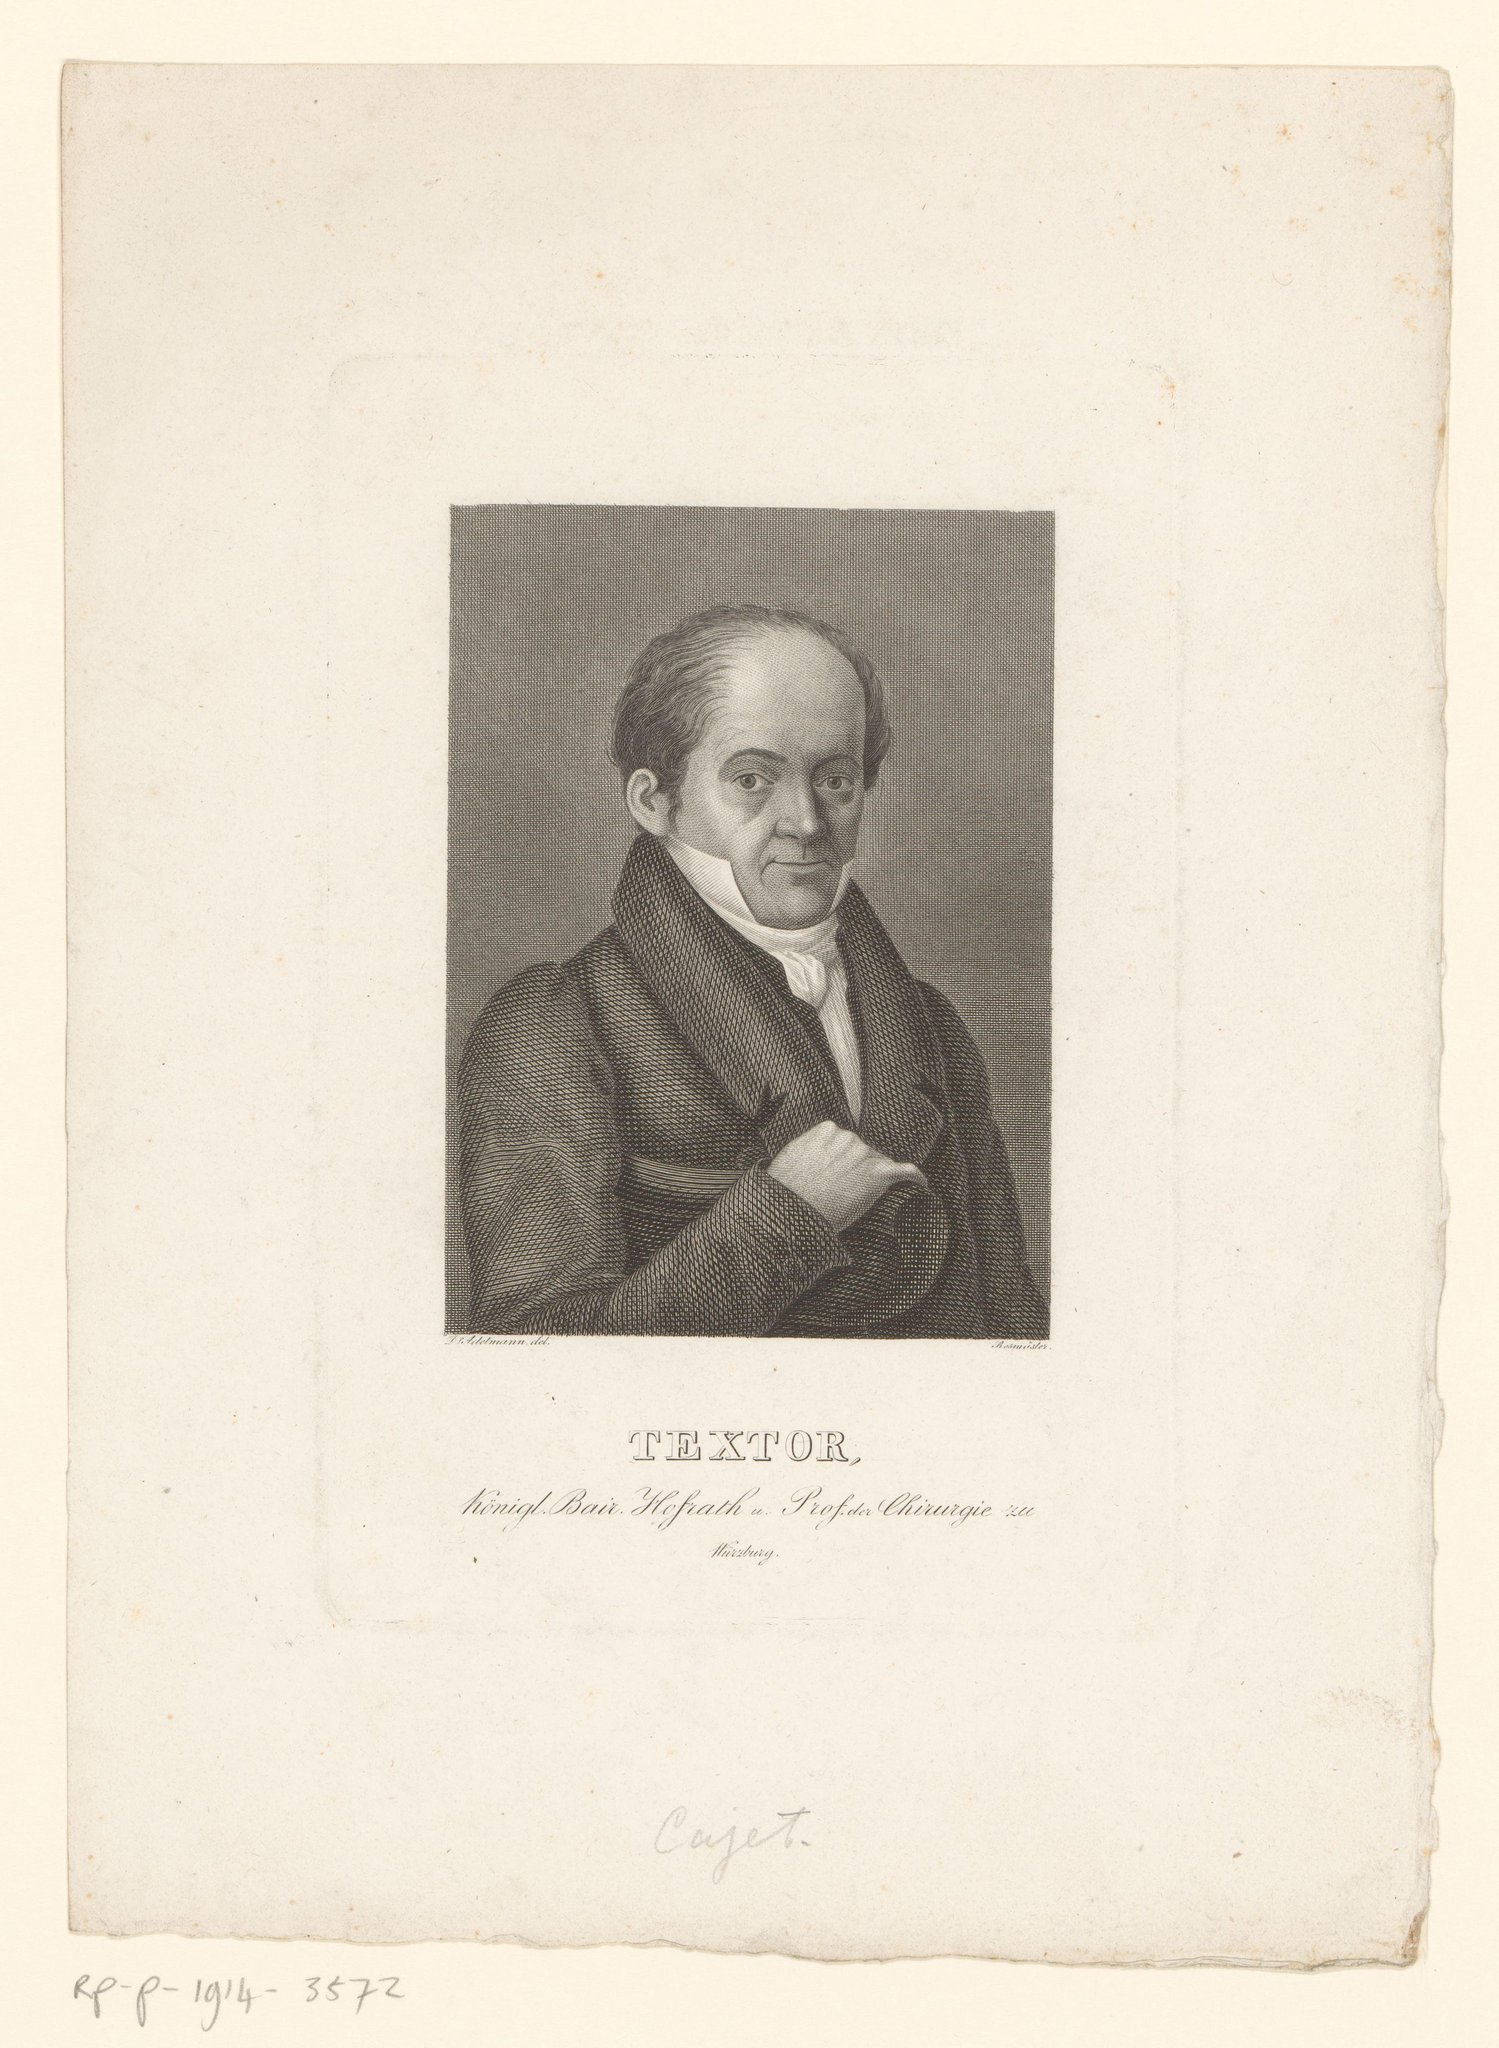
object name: print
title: Portret van Cajetan von Textor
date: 1785-1858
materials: paper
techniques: engraving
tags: historical persons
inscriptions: collector's mark: Lugt 2228